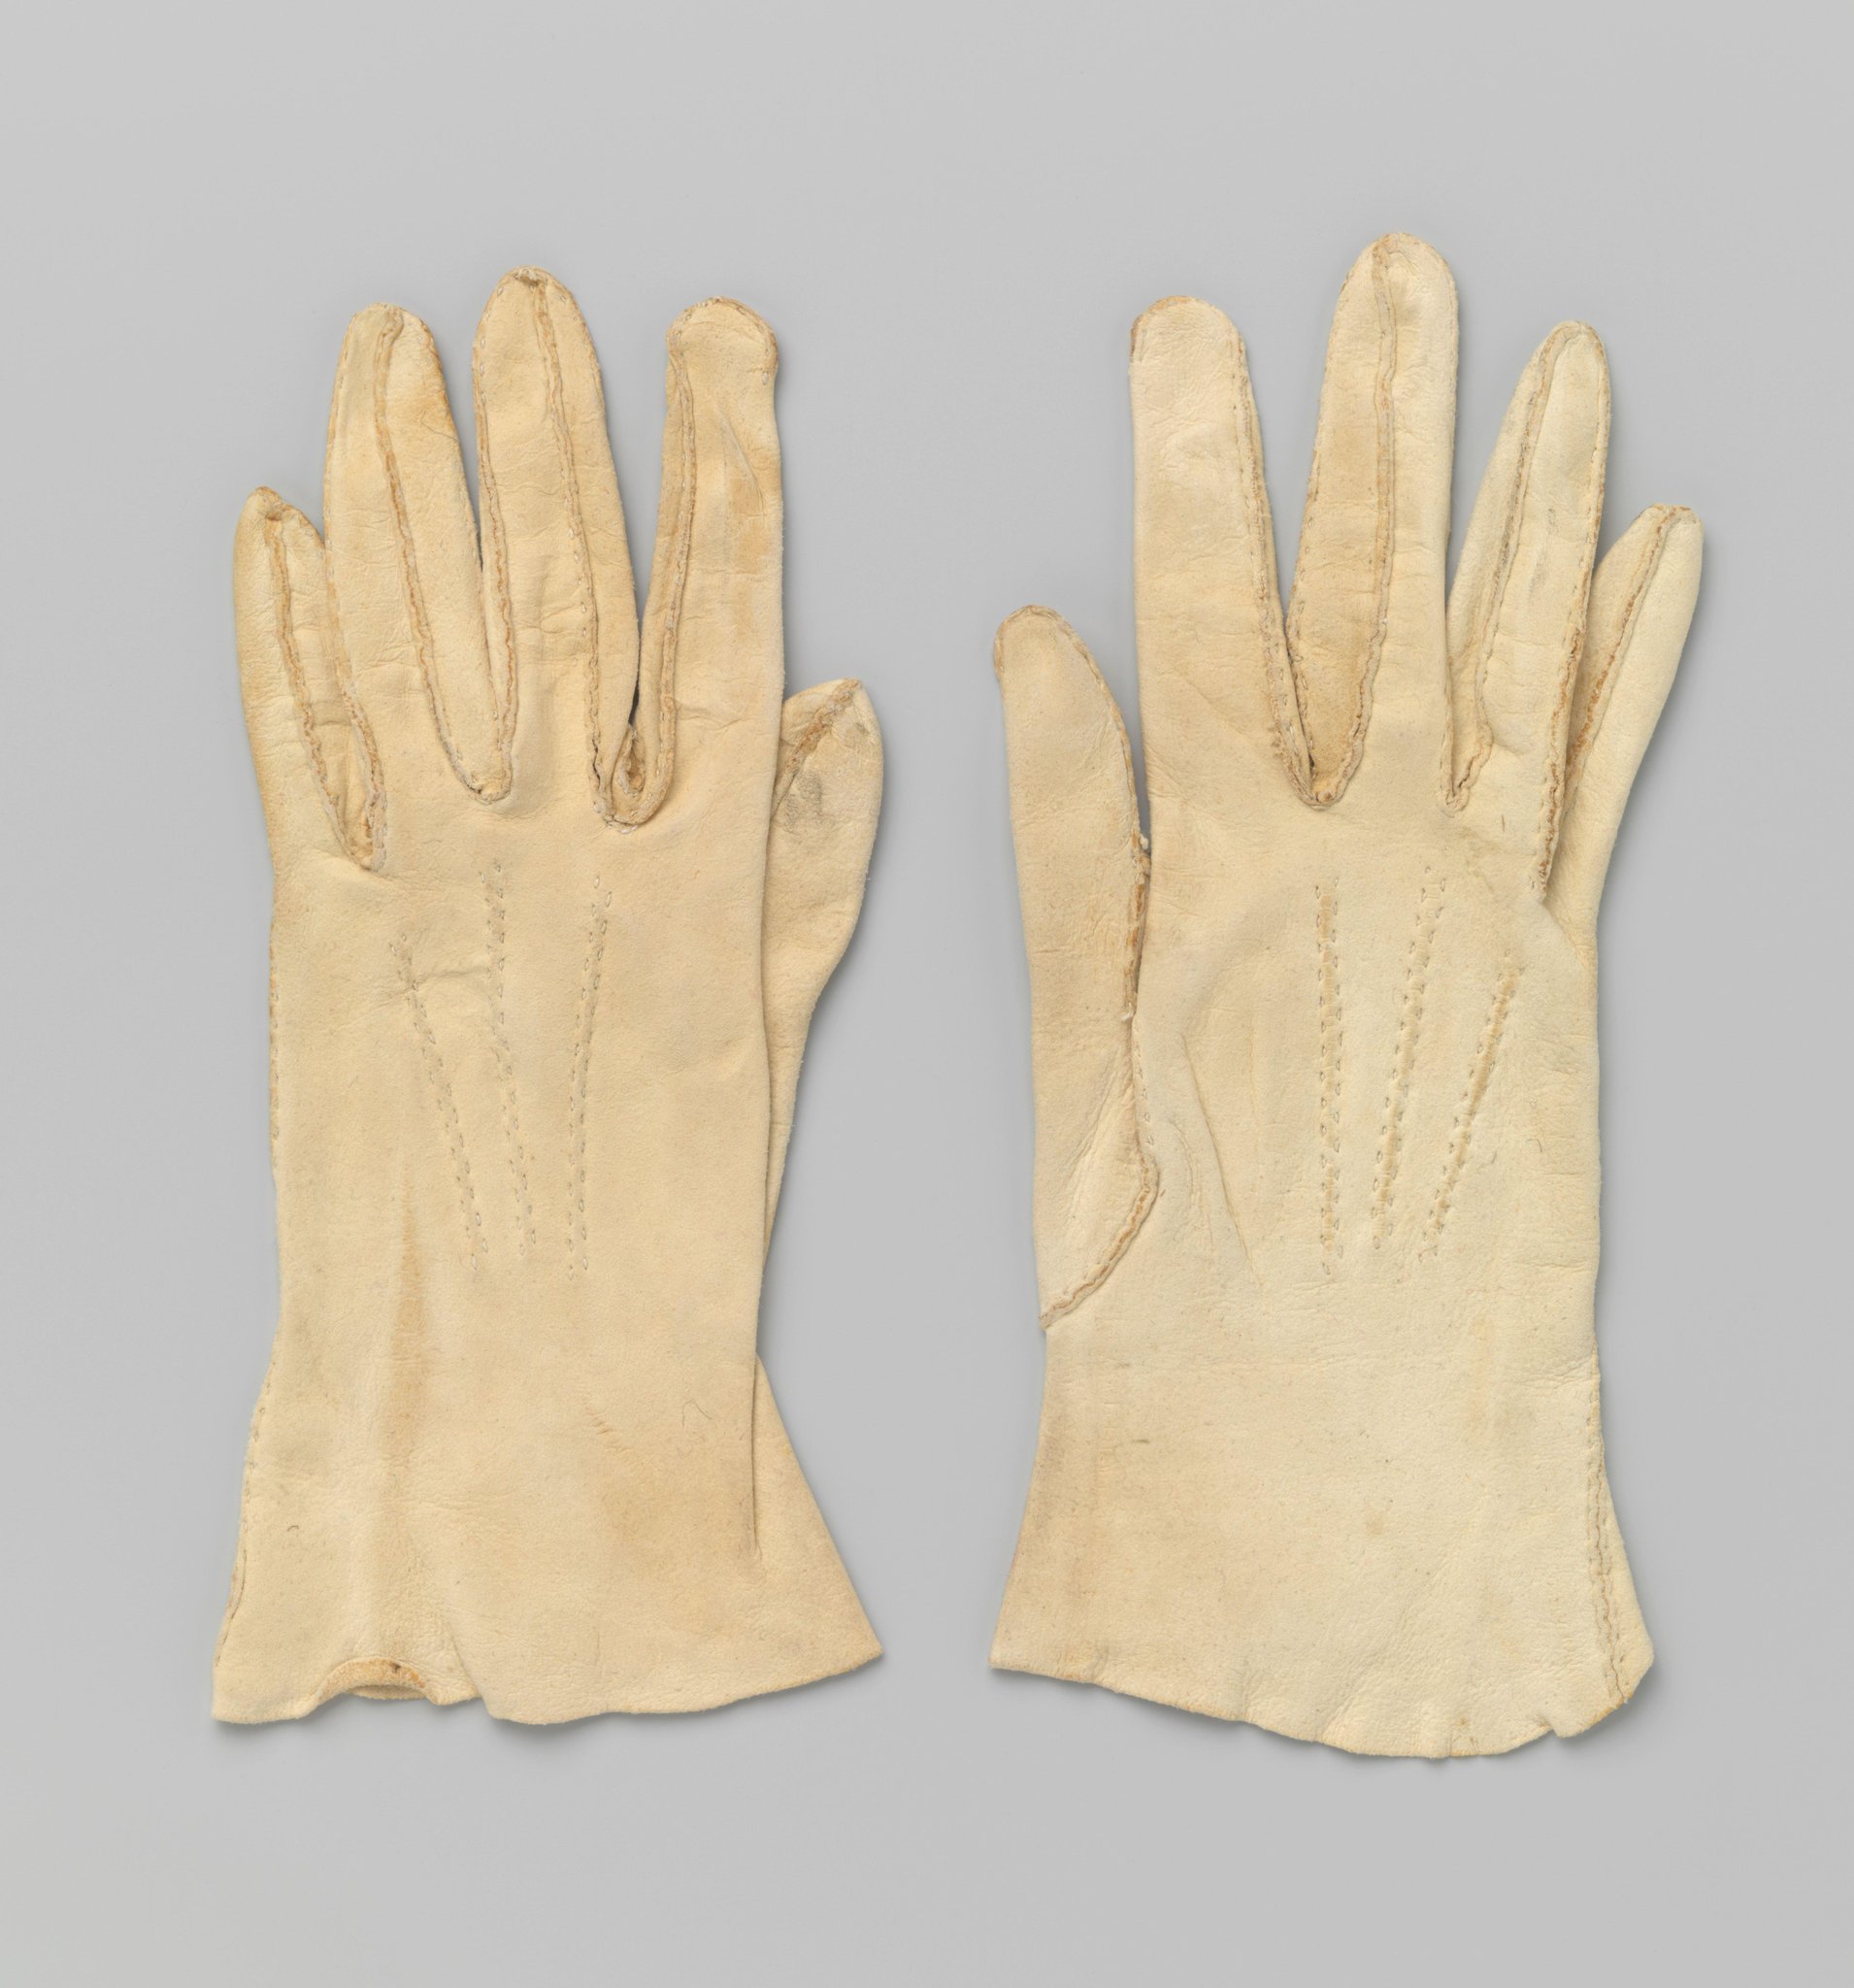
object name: glove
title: Handschoen van beige zeemleer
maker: Anonymous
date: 1900-1915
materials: leather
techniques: quilting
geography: western europe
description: Rechterhandschoen van beige zeemleer. Versierd met drie doorgestikte lijnen op de rug.